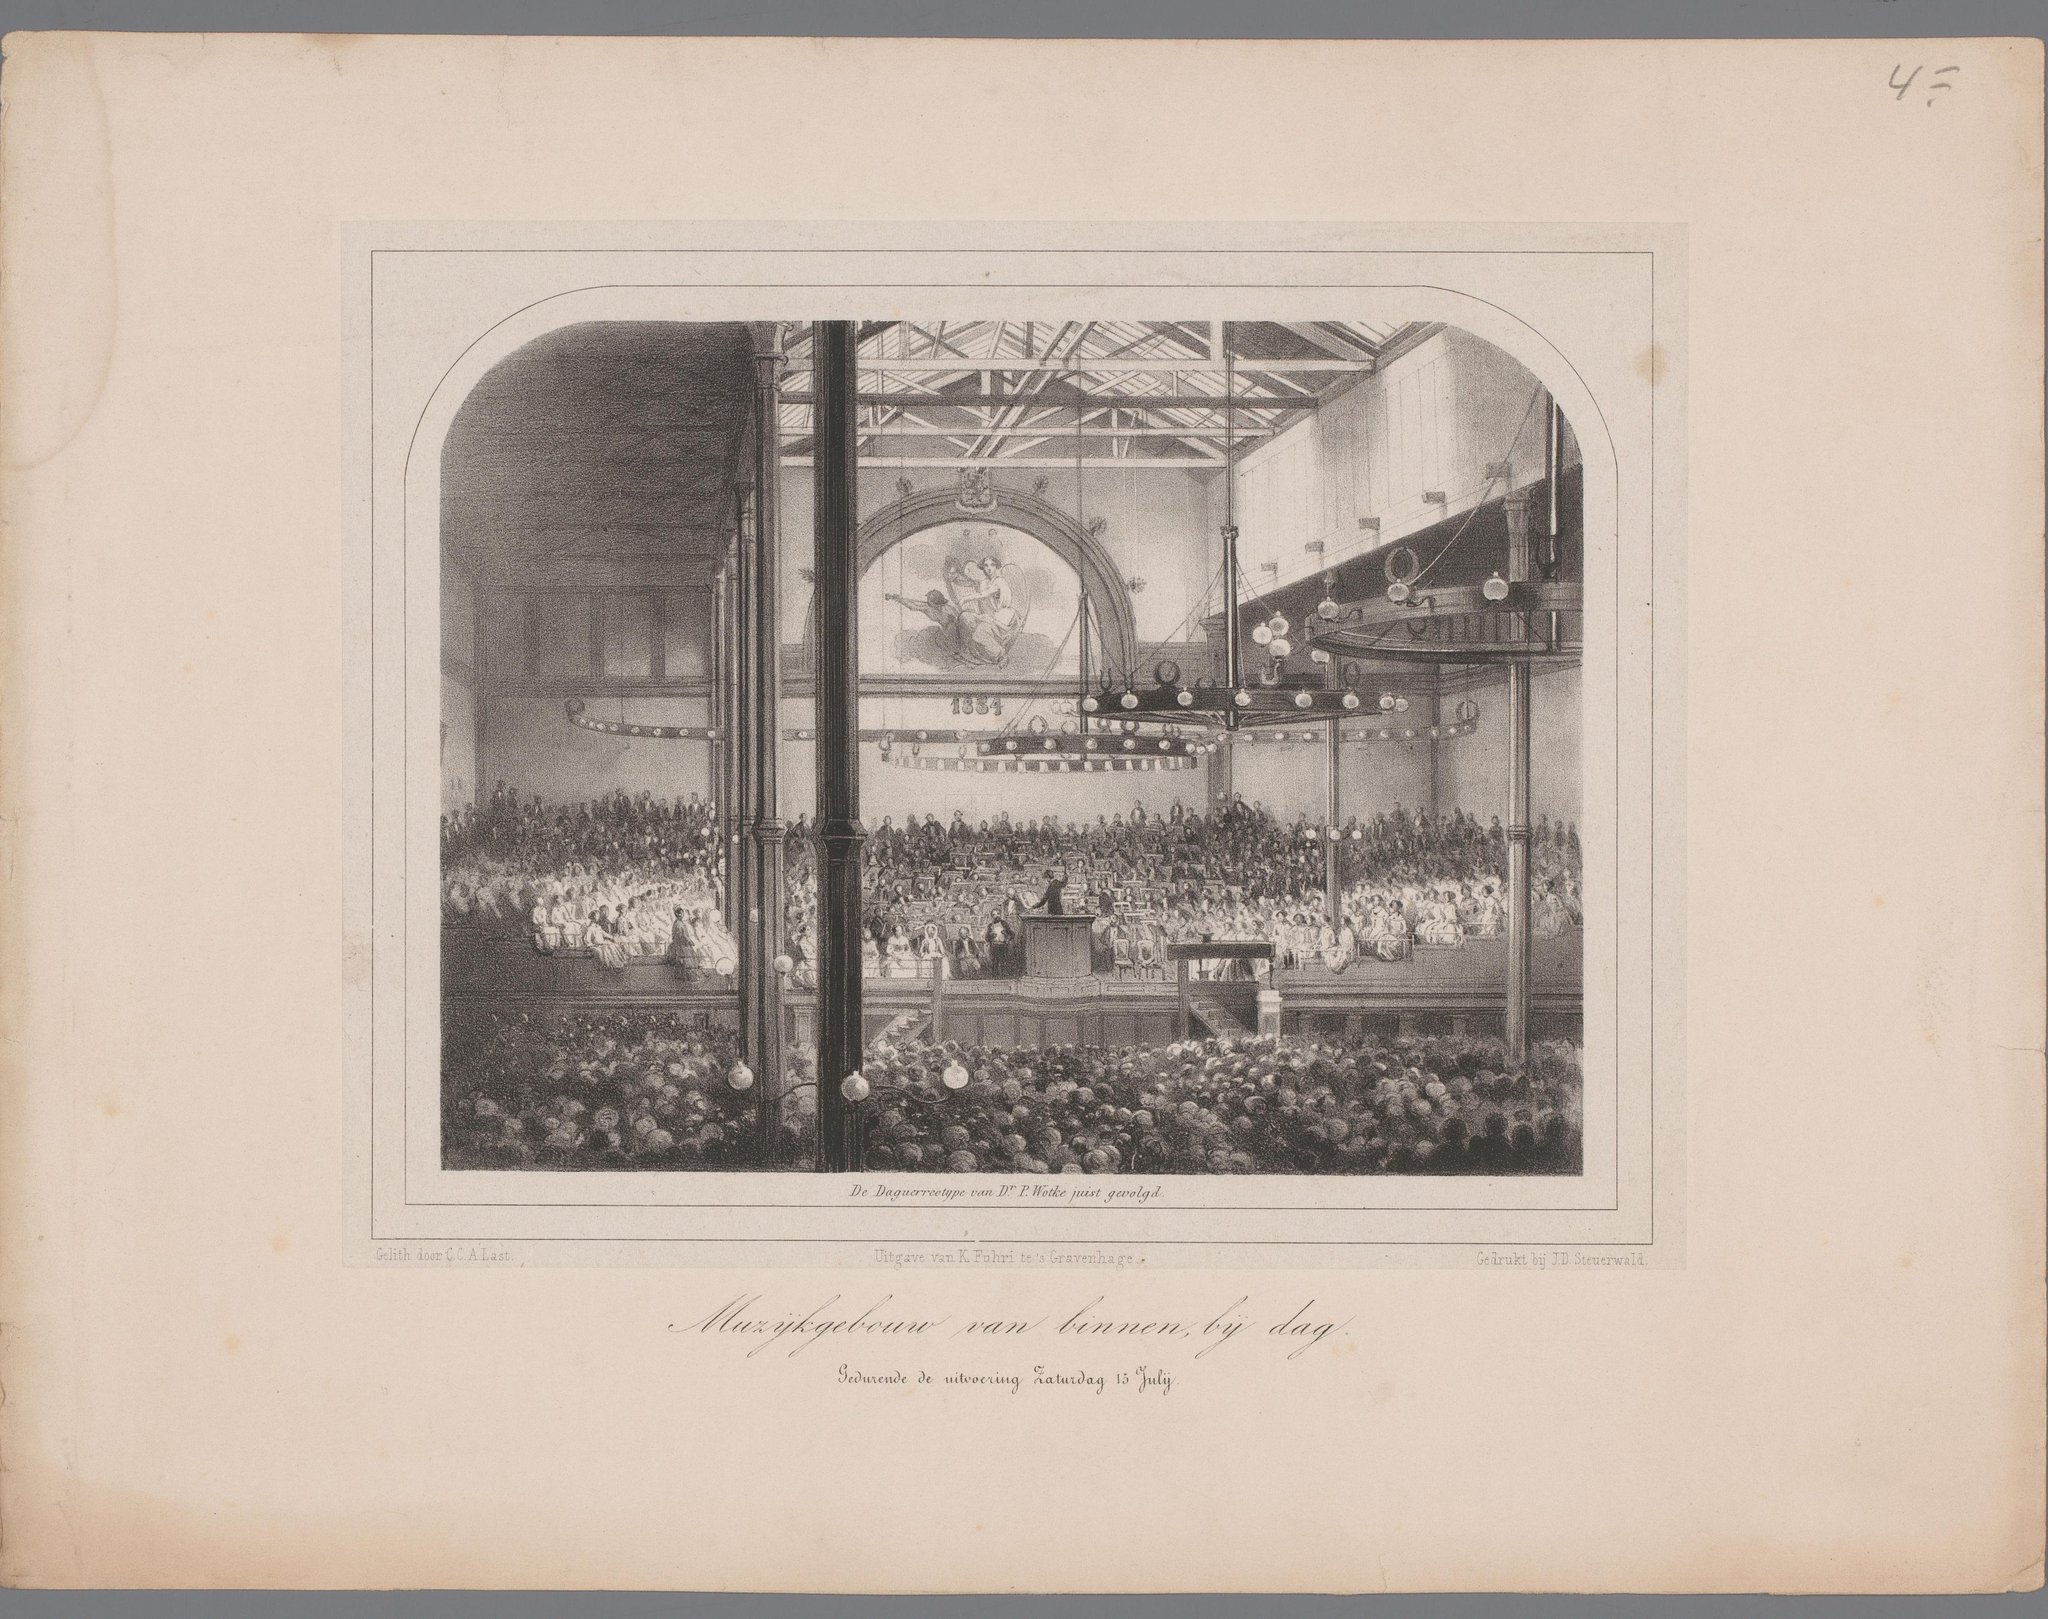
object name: print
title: De Maatschappij ter Bevordering van Toonkunst, haar Muziekfeest en de stad Rotterdam. herinnering aan het jaar 1854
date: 1855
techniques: lithograph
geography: netherlands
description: Gezicht in het interieur van het nieuwe Feestgebouw waar in het kader van het muziekfeest een concert wordt gegeven, 15 juli 1854. Onderdeel van een serie van twaalf portretten naar daguerrotypieën en twaalf stadsgezichten. Ter gelegenheid van het Muziekfeest ter viering van het 25-jarige bestaan van de Maatschappij ter Bevordering van Toonkunst in Rotterdam, 12-15 juli 1854.